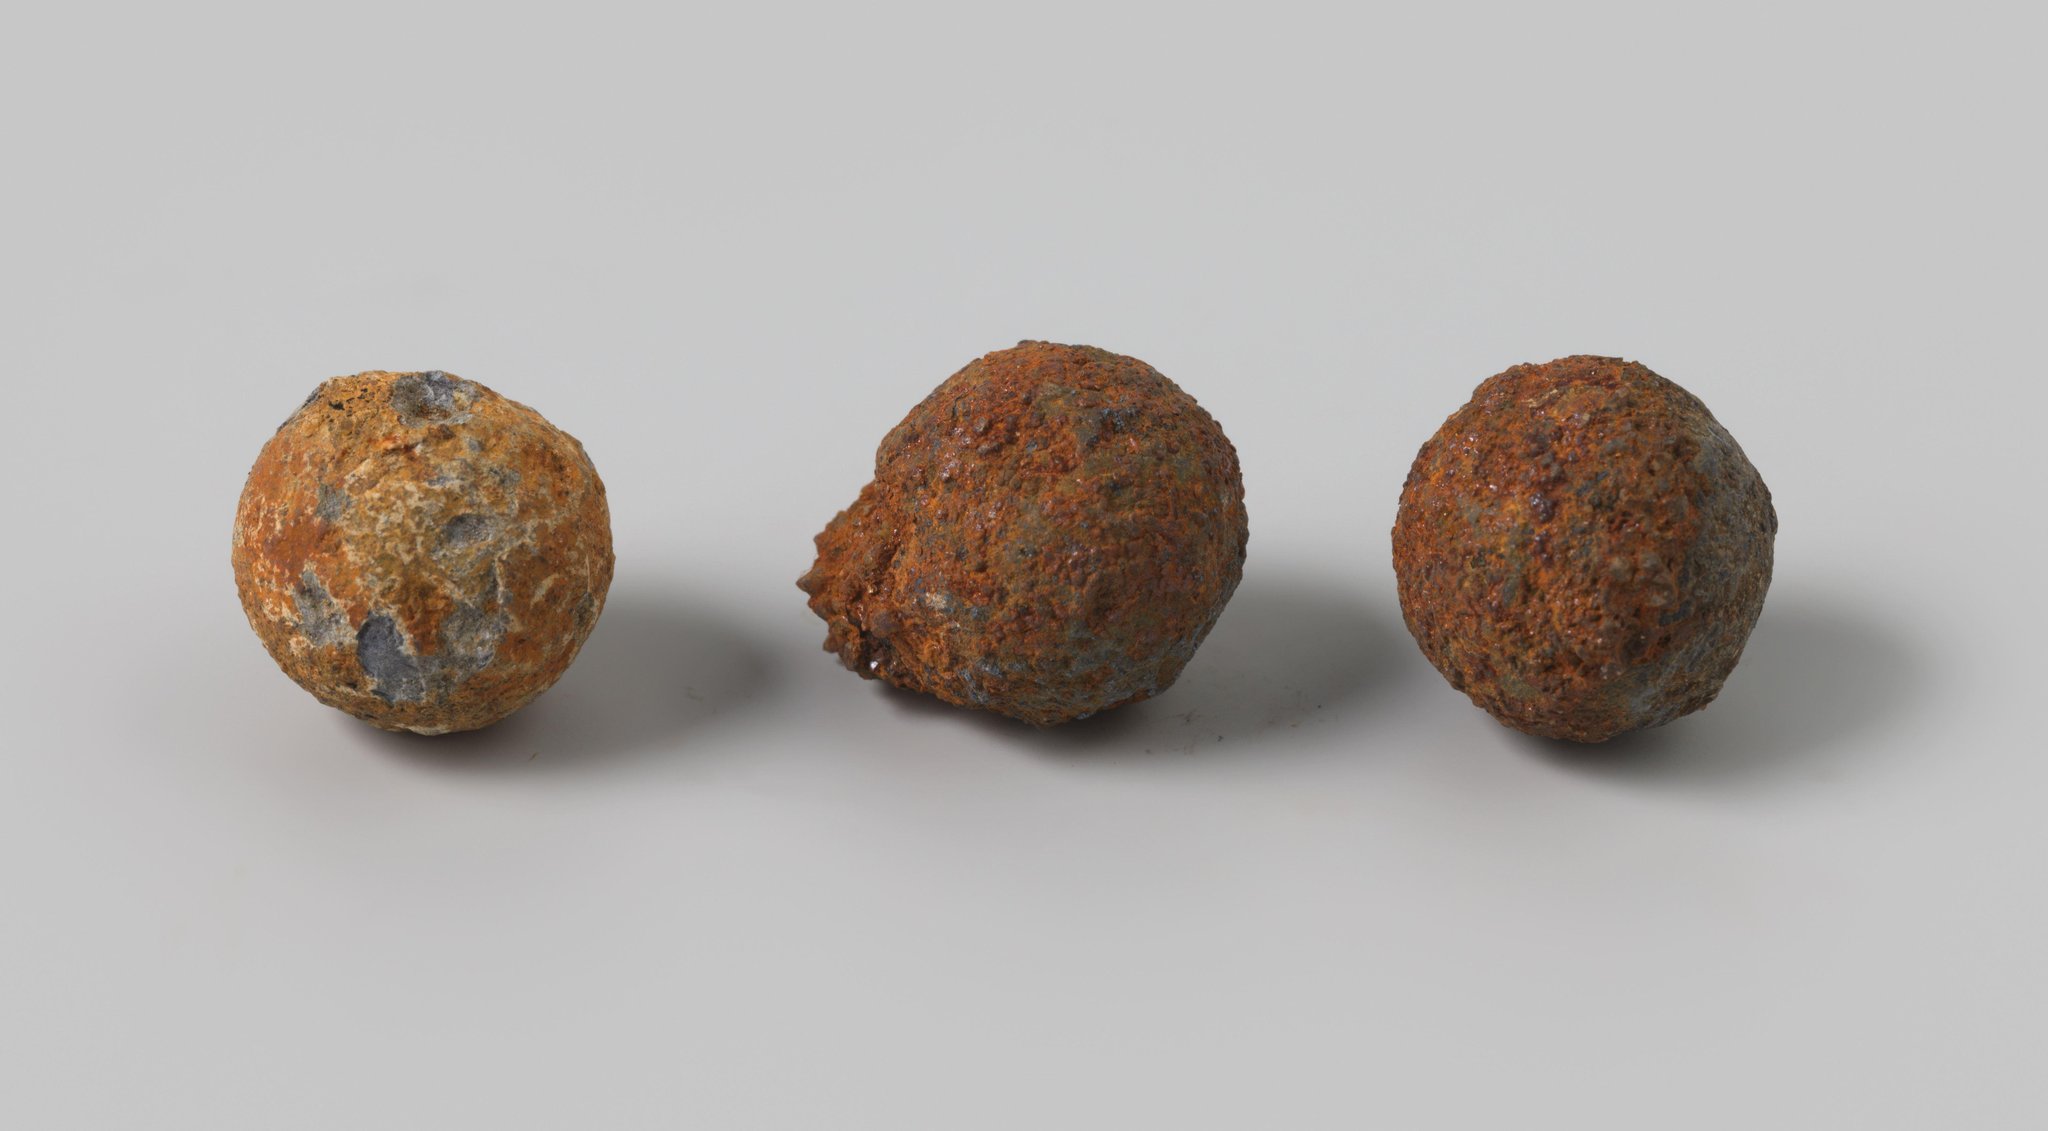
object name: musketkogel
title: Musketkogels uit het wrak van de Oost-Indiëvaarder Hollandia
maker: Anonymous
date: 1700-1743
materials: lead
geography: netherlands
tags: verenigde oostindische compagnie, hollandia (schip), annet